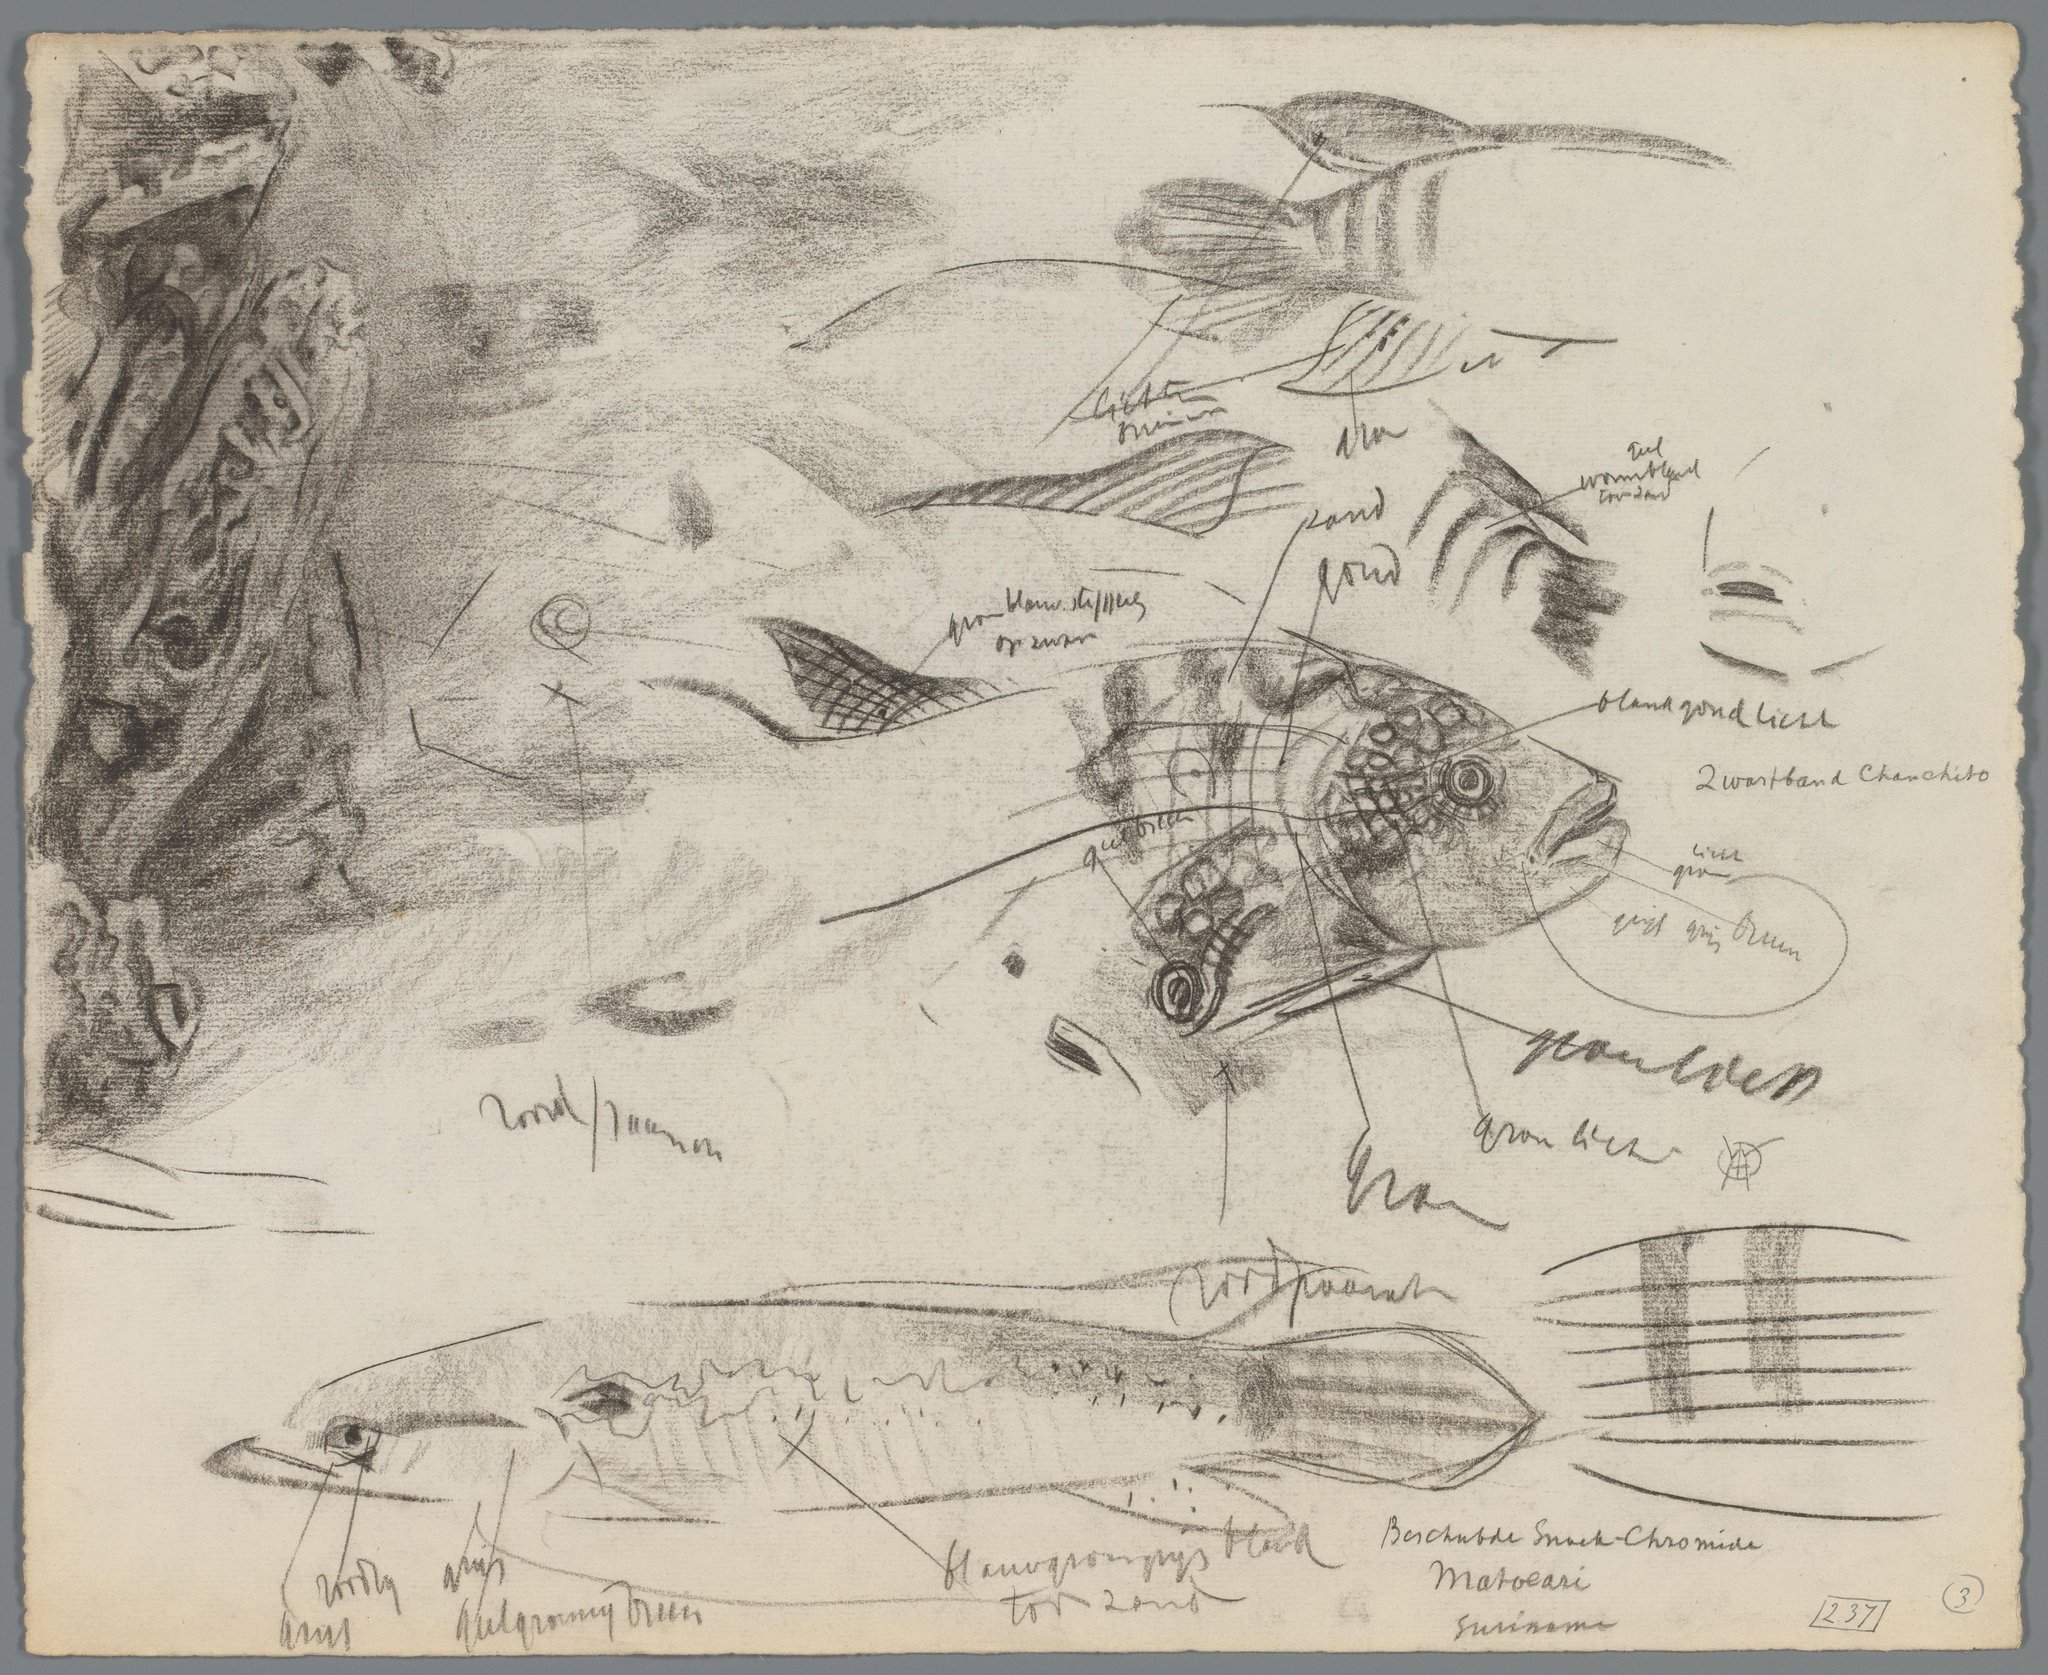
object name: drawing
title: Studieblad met vissen en een deel van een aquarium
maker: gerrit willem dijsselhof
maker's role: designer, draughtsman, print maker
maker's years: 1866-1924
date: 1876-1924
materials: chalk, paper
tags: aquarium, bony fishes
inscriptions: number: ‘3’, number: ‘237’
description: Met een cichlide en een kleine snoeksoort.